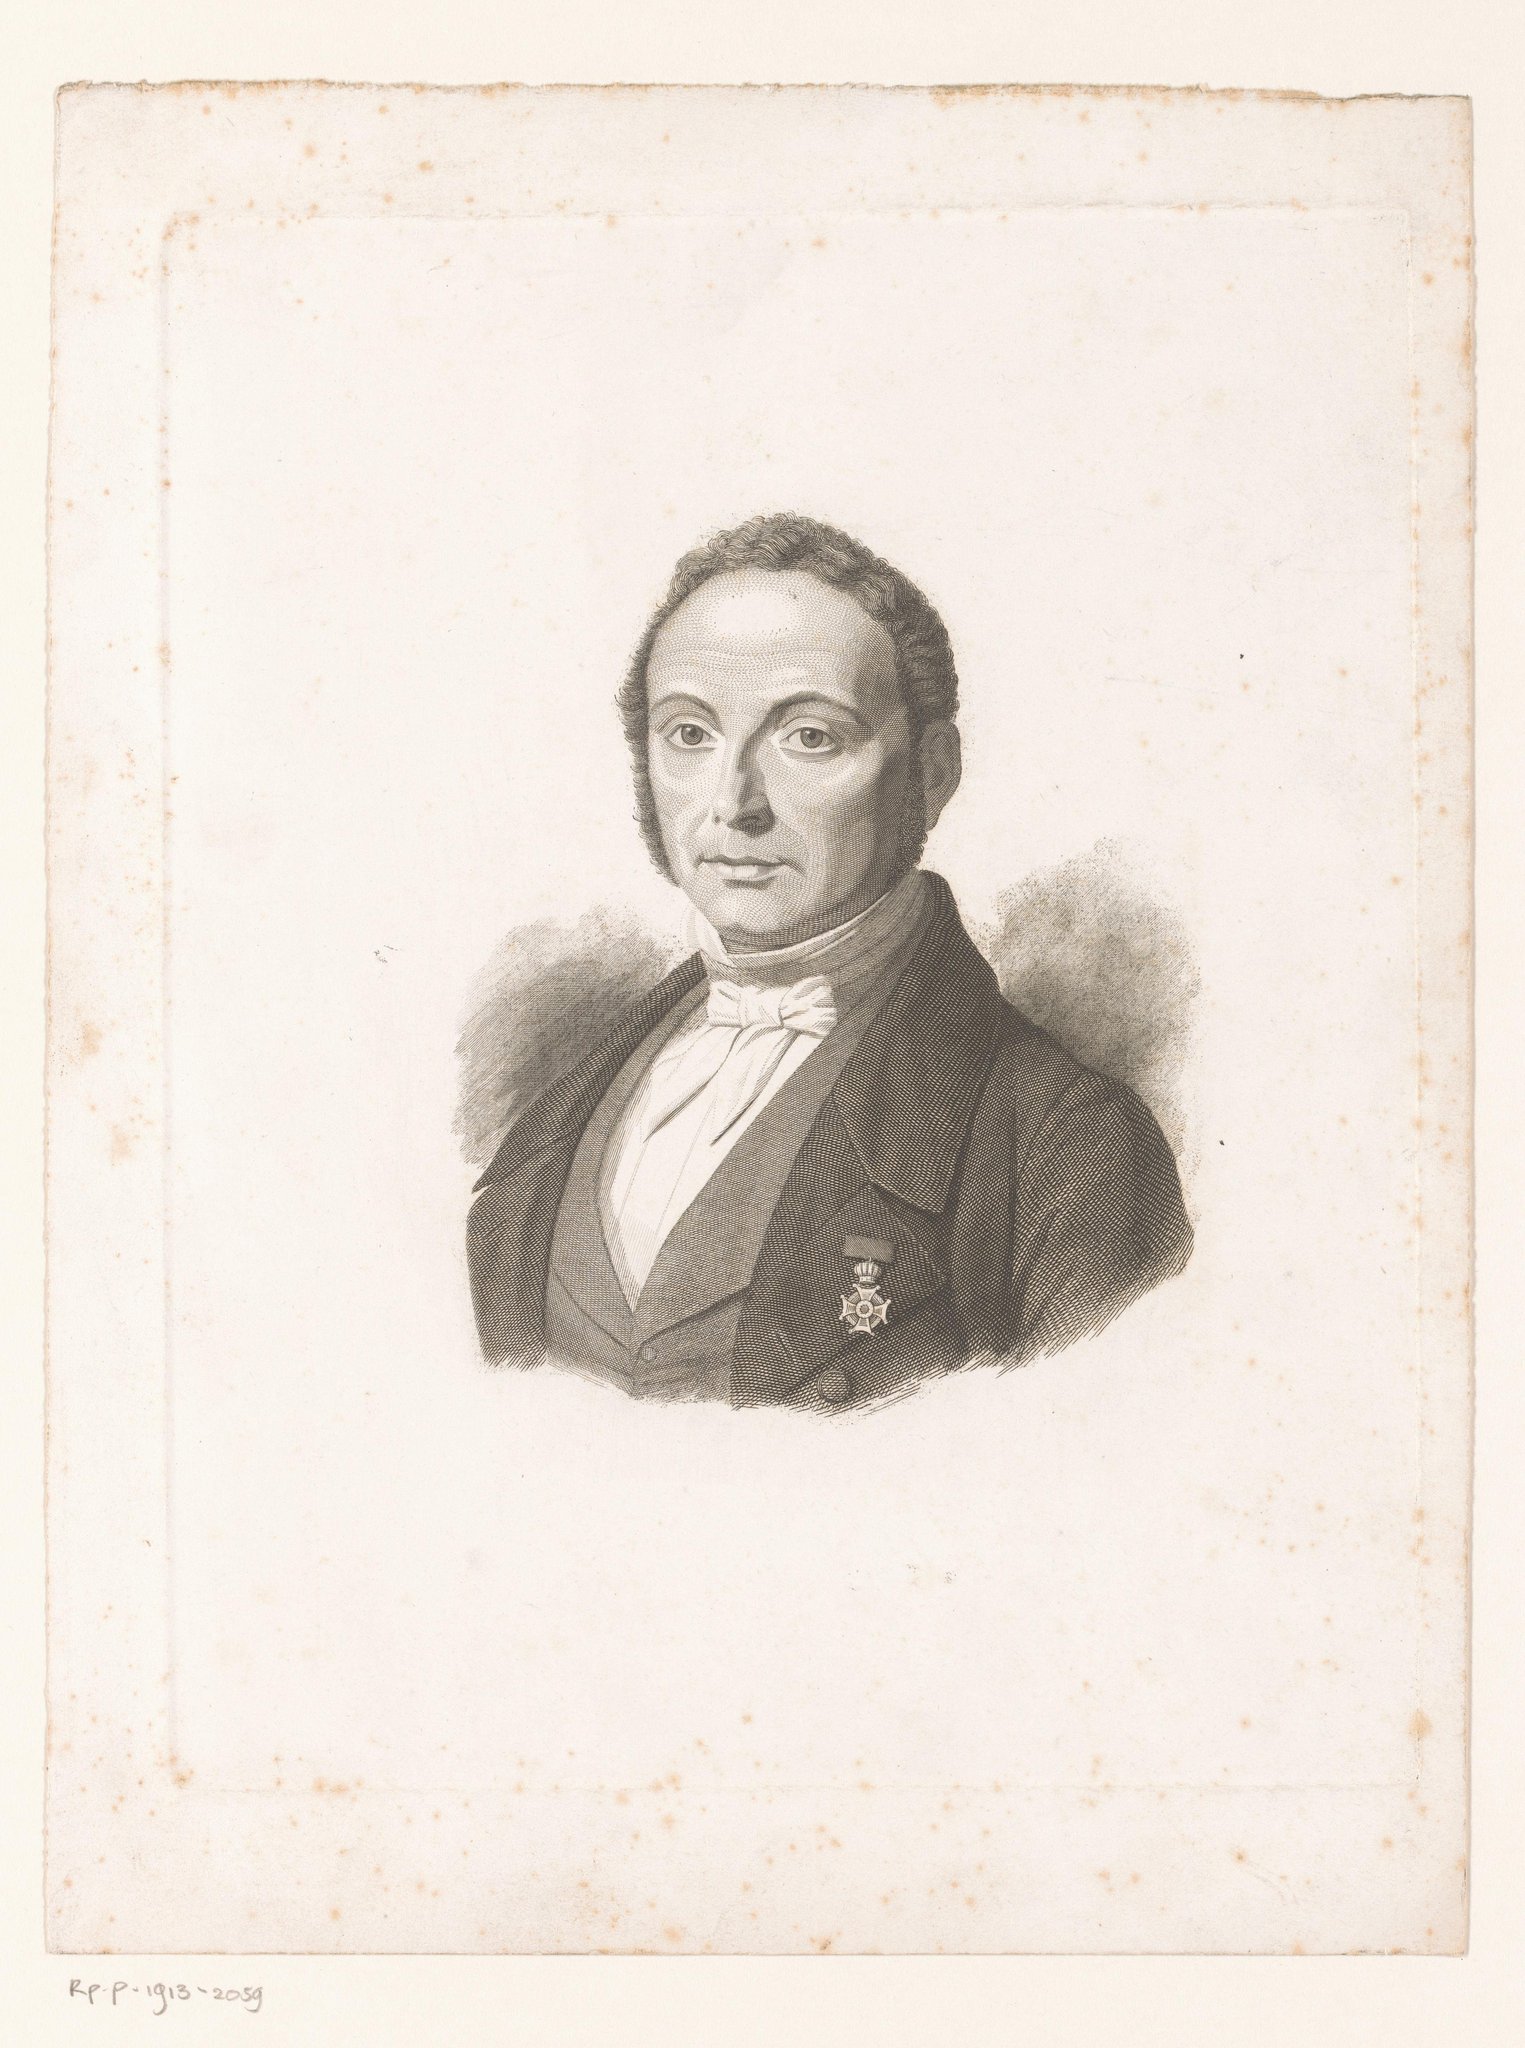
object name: print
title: Portret van N. Stevens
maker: josephus nauwens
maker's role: print maker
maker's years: 1830-1906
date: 1858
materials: paper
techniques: engraving, etching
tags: adult man, historical persons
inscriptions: collector's mark: Lugt 2228